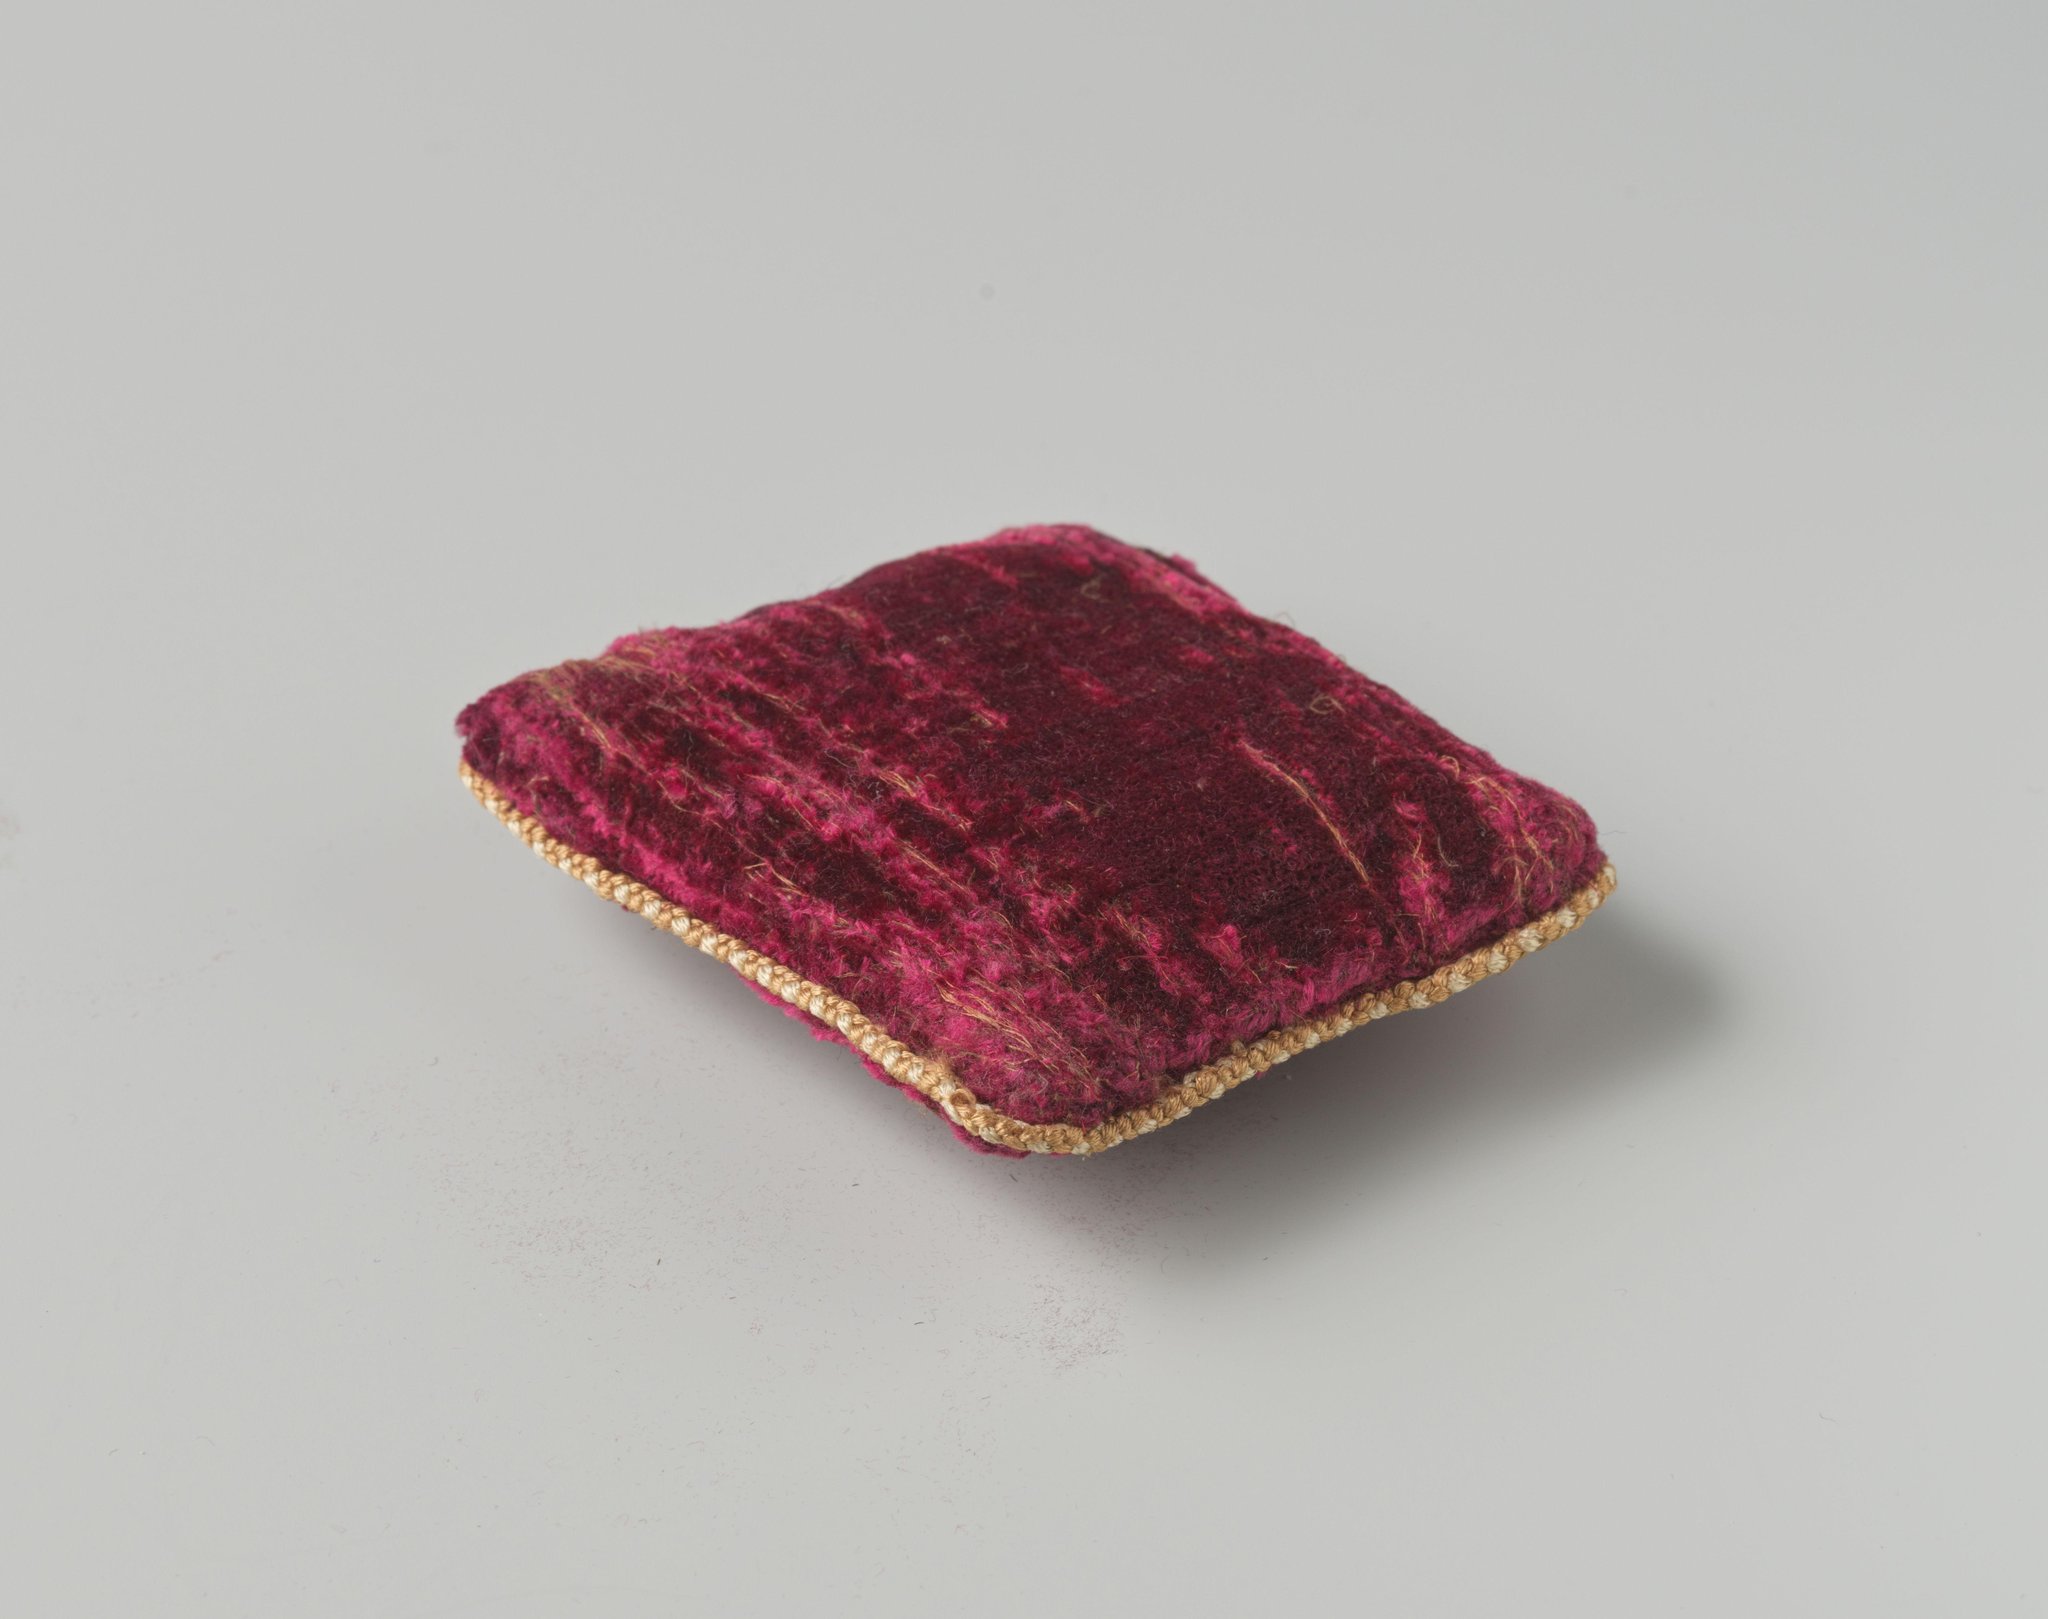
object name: miniature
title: Stoelkussen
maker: Anonymous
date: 1690-1710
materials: down, silk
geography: amsterdam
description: Rechthoekige dikke stoelkussen van bordeaux rode zijden fluweel, rondom afgezet met wit / bruin gevlochten koord van zijde. De vulling van dons was oorspronklijk zonder binnenhoes in het kussen gestopt.